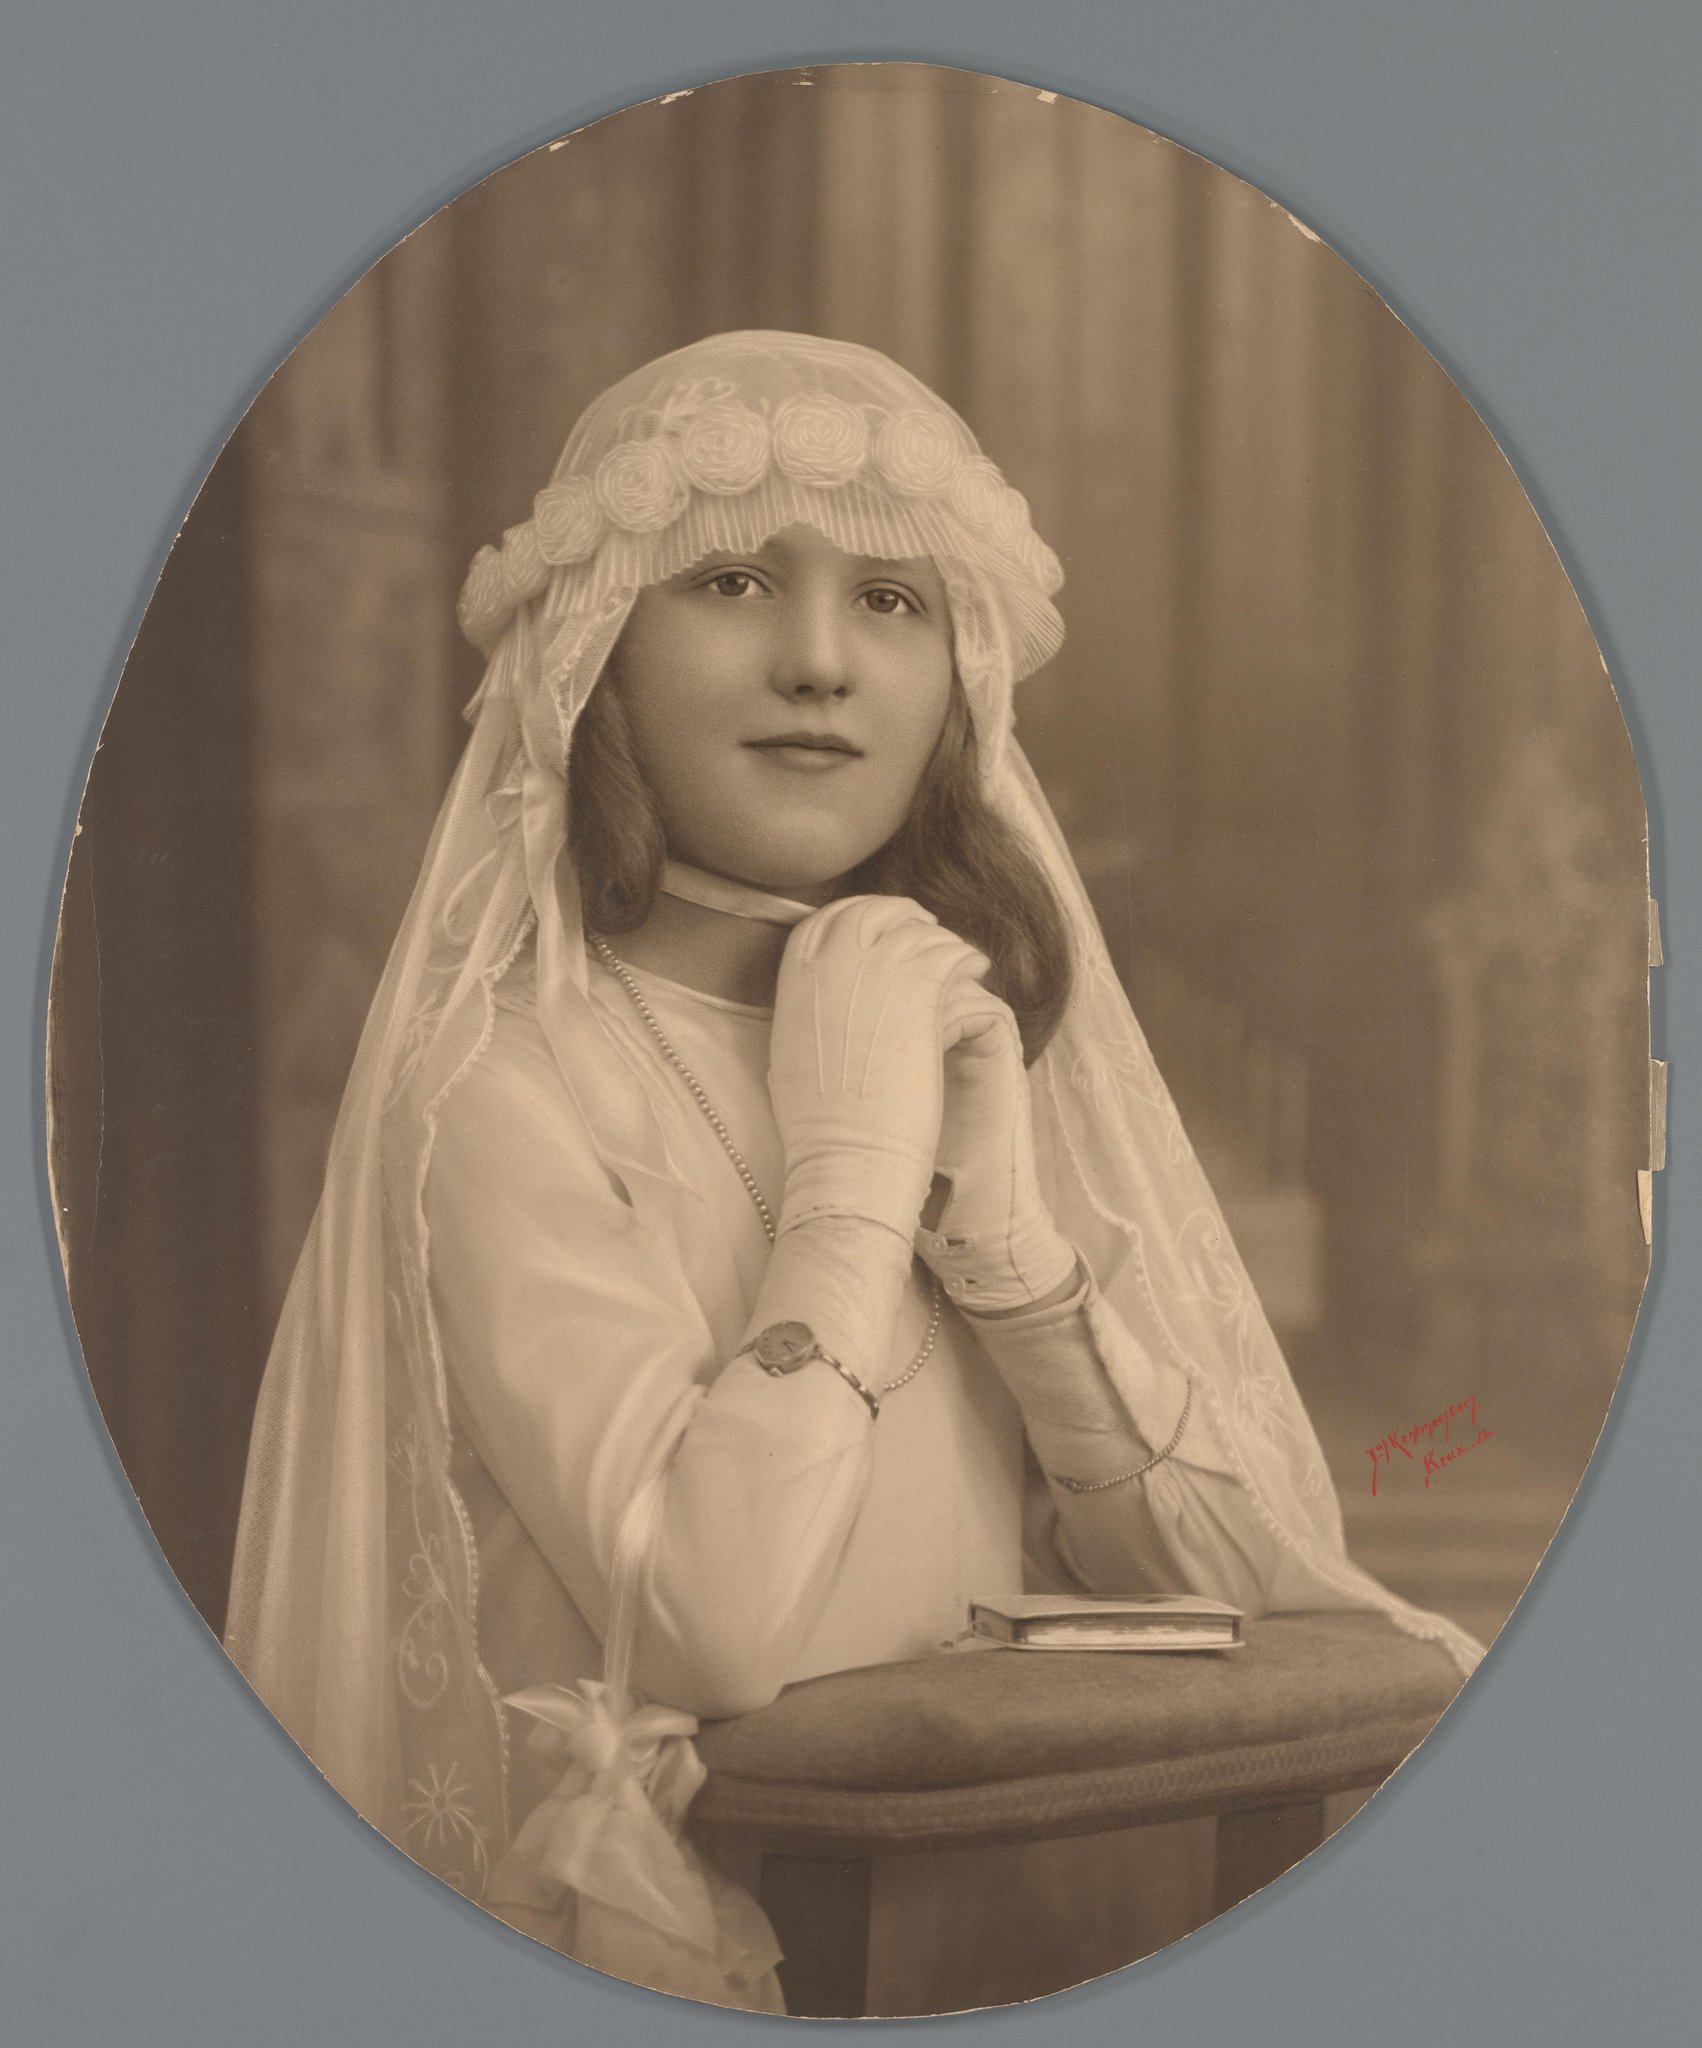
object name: photograph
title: Portret van een onbekend meisje als communicant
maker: jos. rentmeesters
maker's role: fotograaf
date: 1910-1920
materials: paper, cardboard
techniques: gelatin silver print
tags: girl (child between toddler and youth), anonymous historical person portrayed